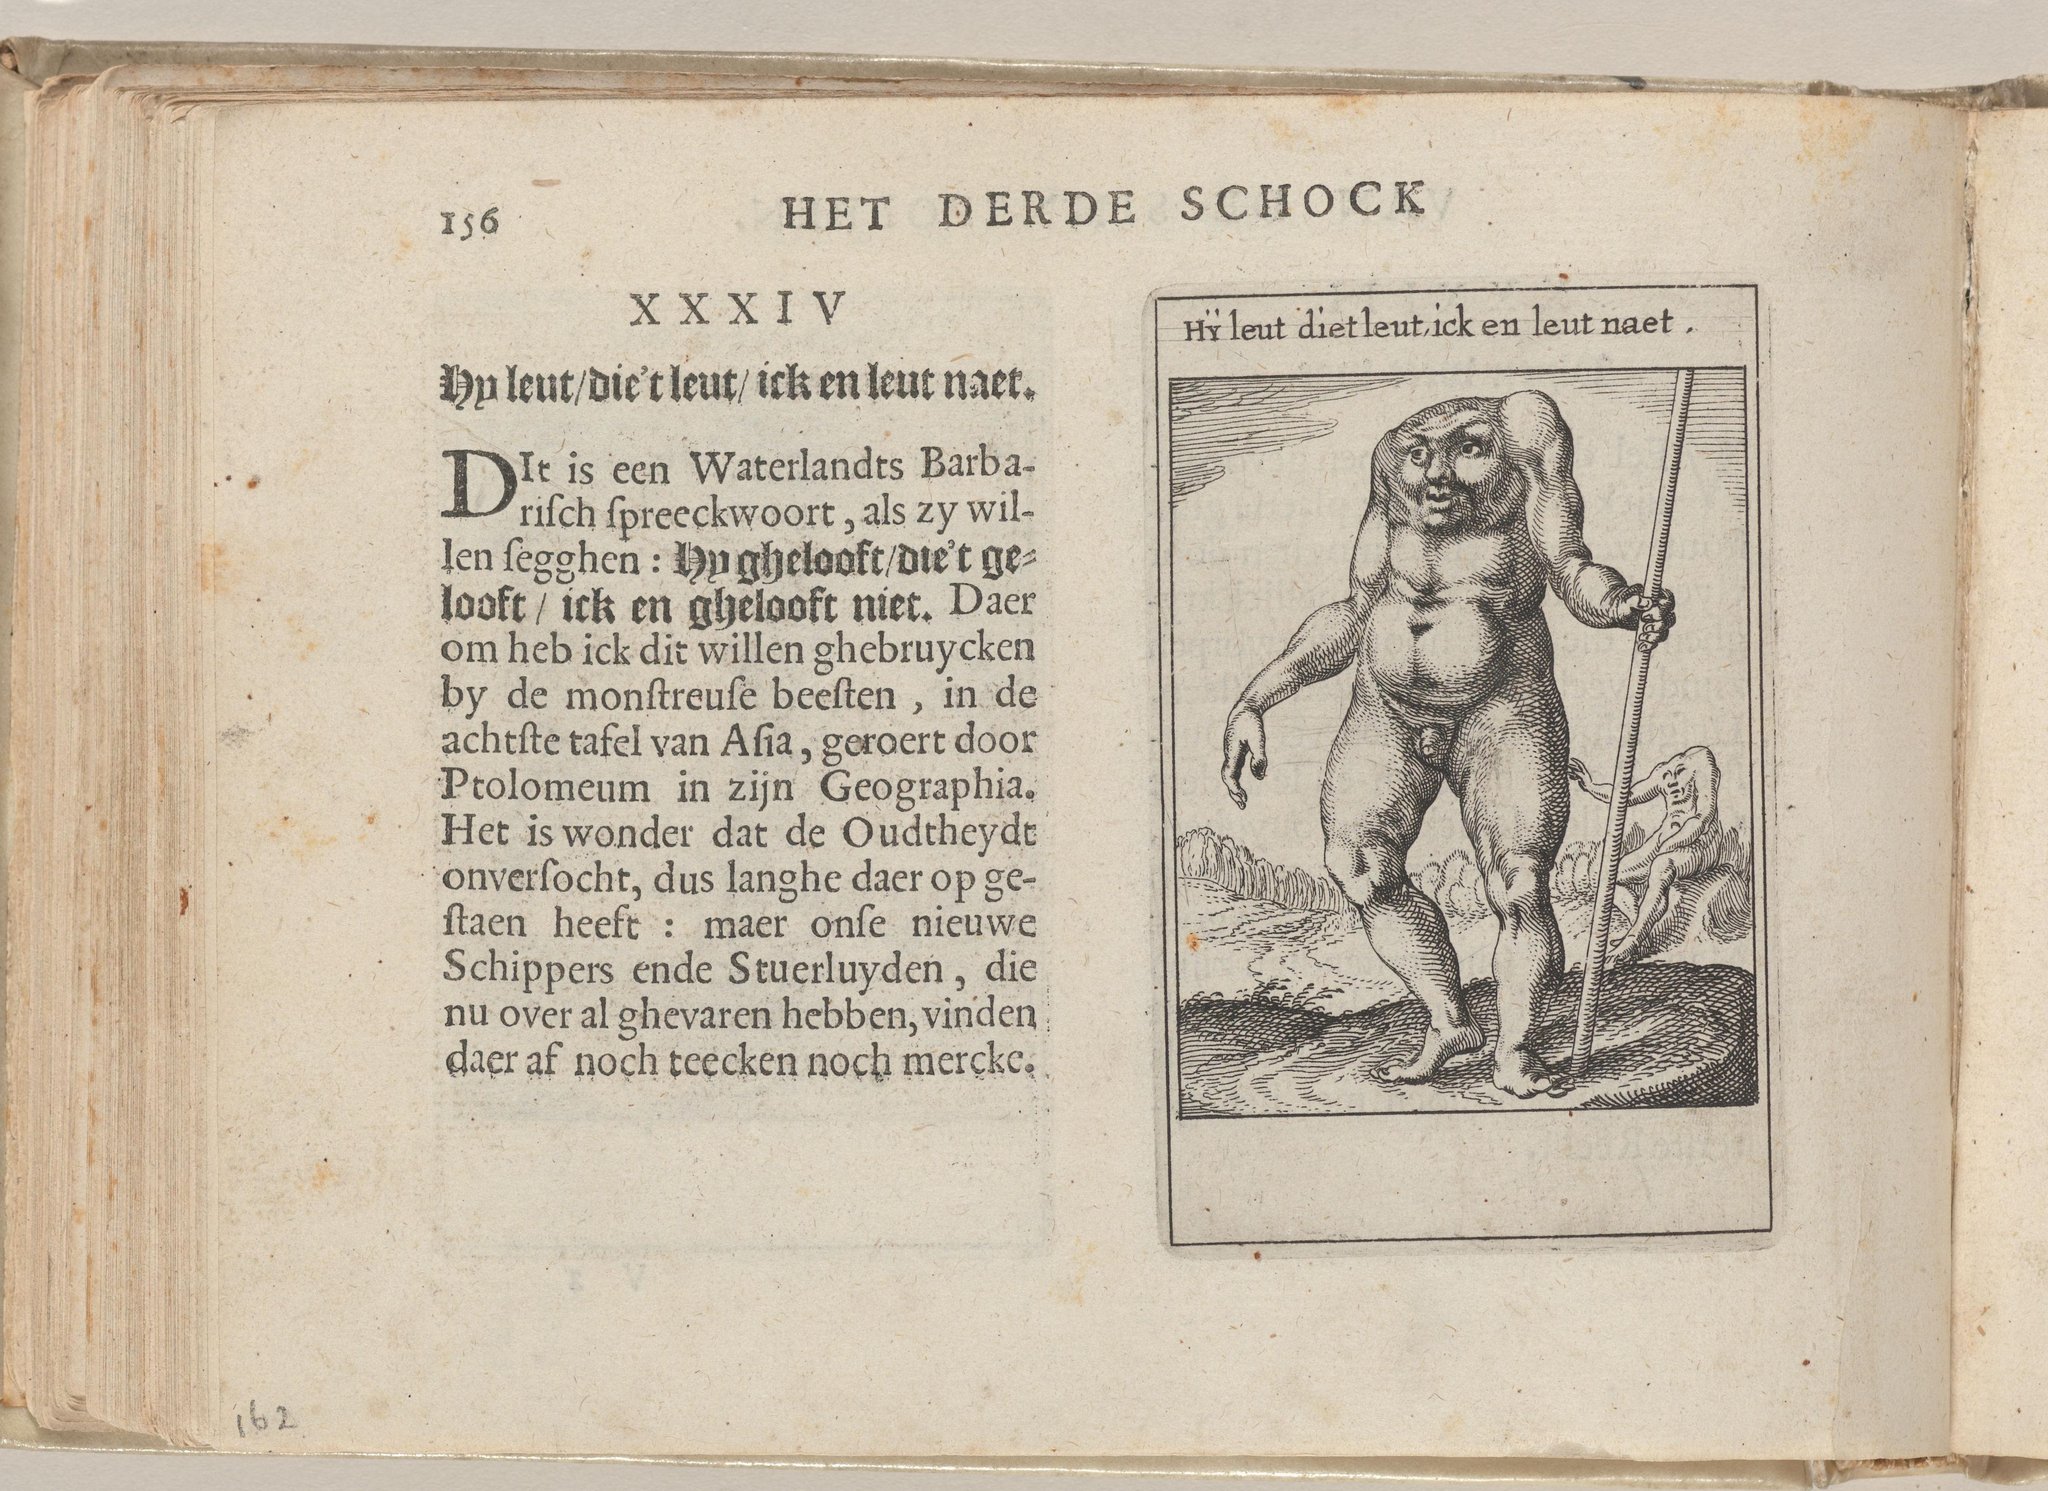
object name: album leaf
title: XXXIV Hy leut diet leut ick en leut naet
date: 1614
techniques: engraving, printing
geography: amsterdam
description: XXXIV Hy leut diet leut ick en leut naet. Derde schok. Onderdeel van 'Sinnepoppen', R. Visscher, 1614.